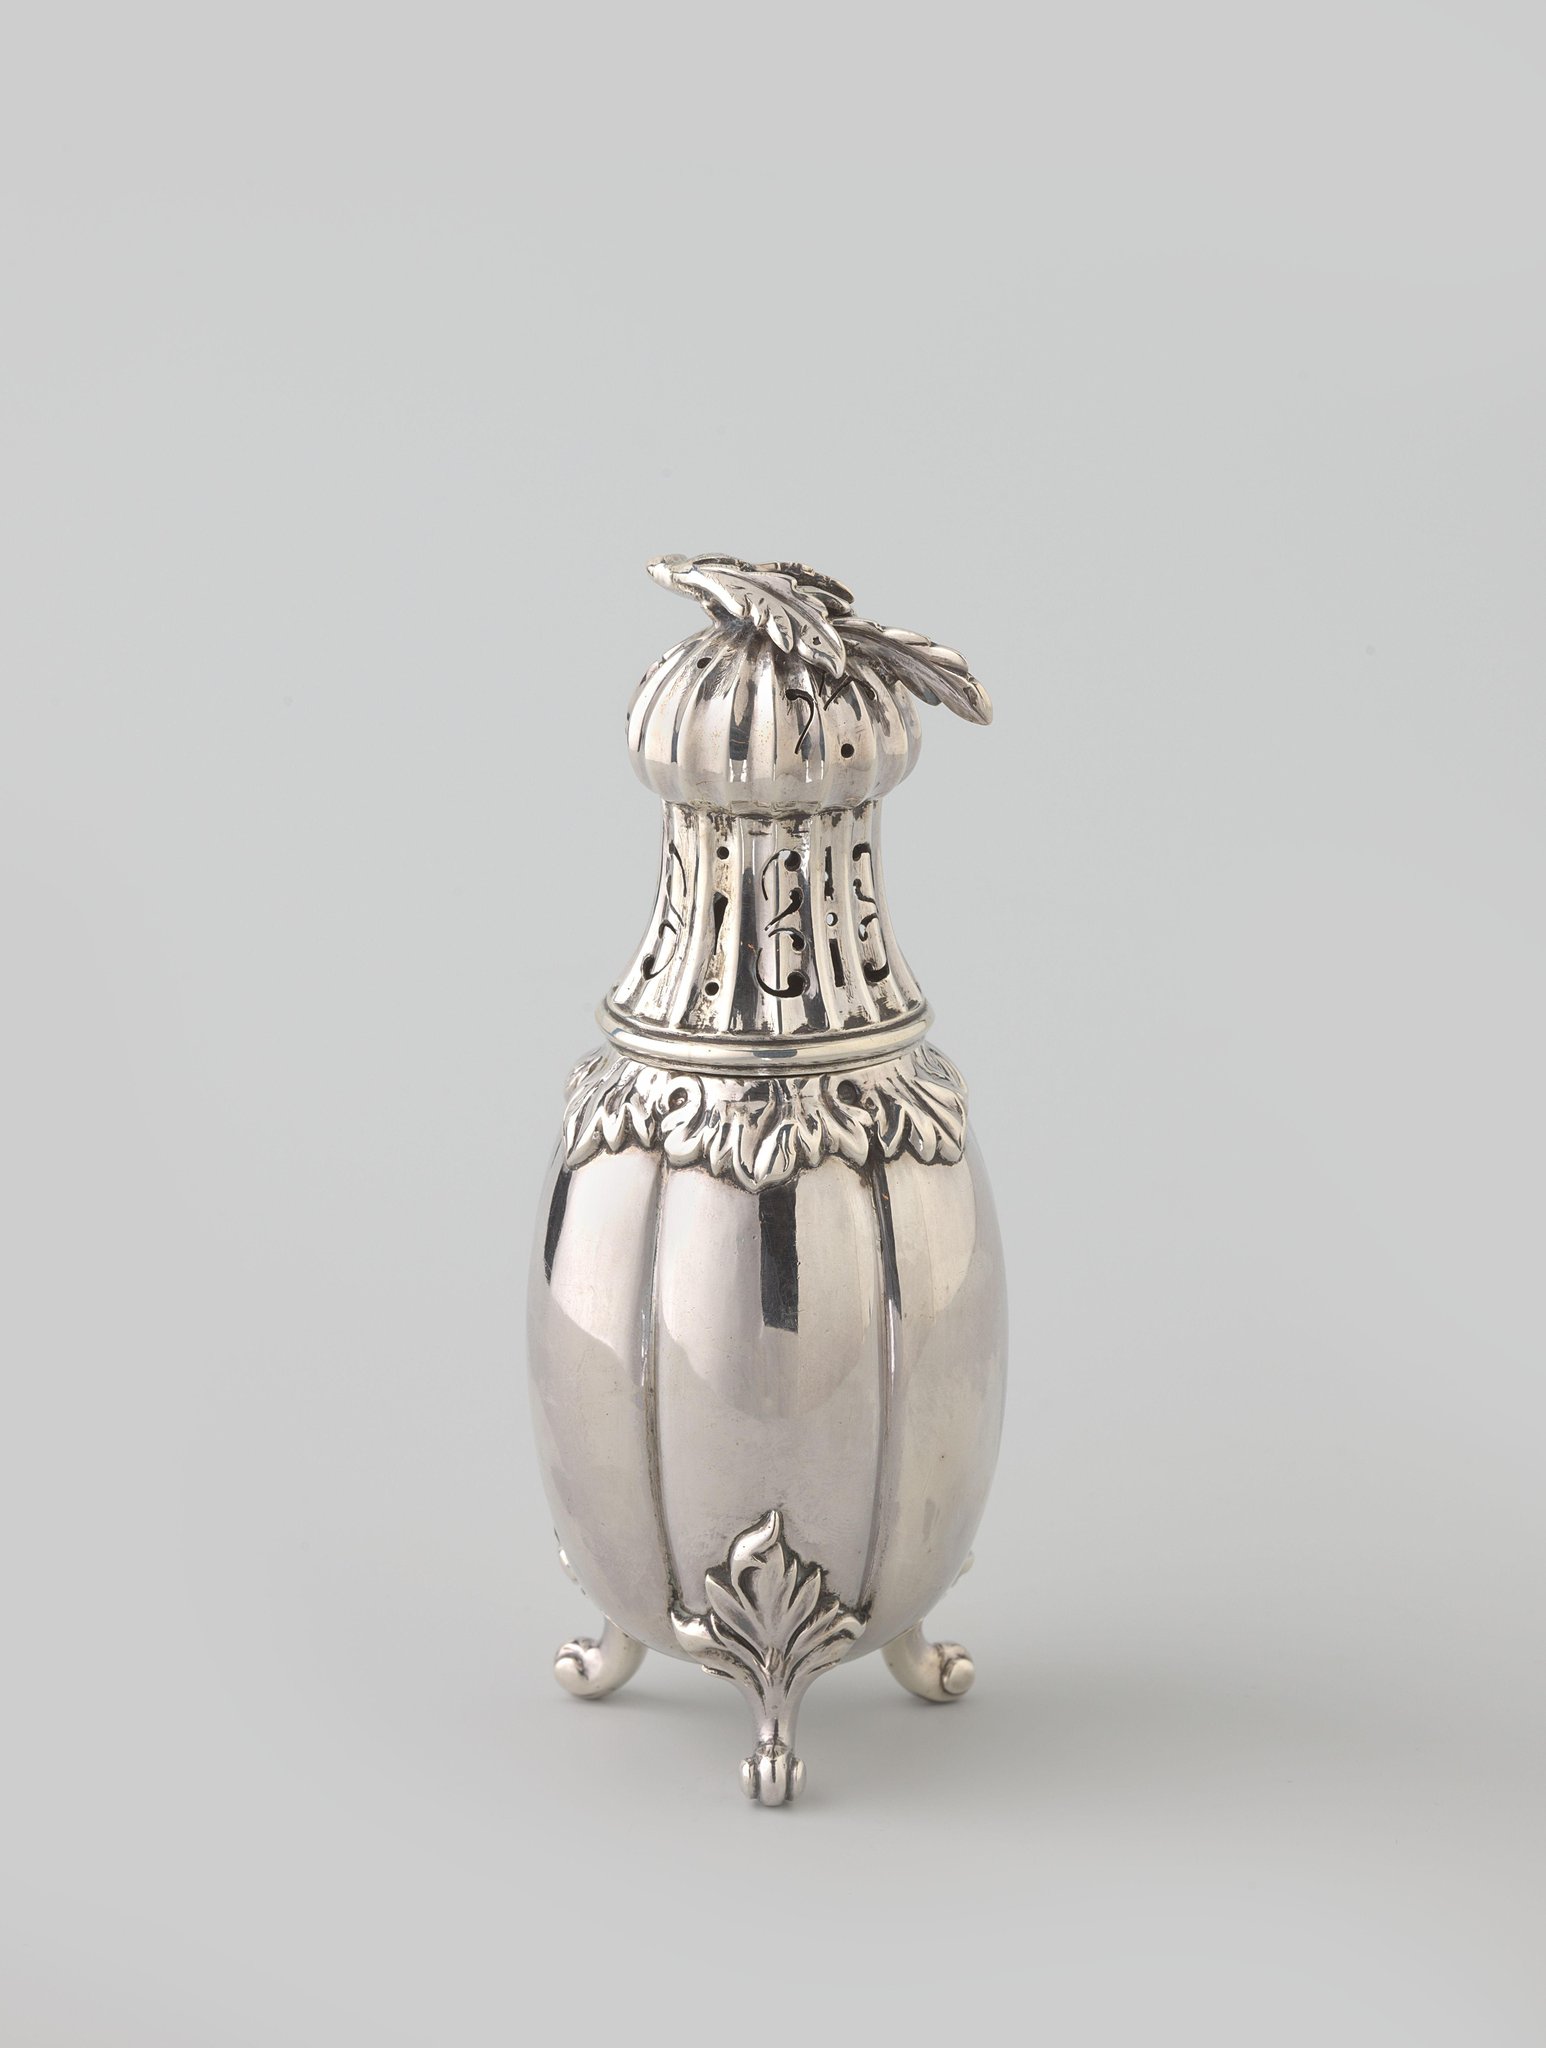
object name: strooibus, strooier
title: Strooibus met meloenvormig lichaam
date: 1944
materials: silver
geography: amsterdam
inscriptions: duty mark (): ‘I’, date letter (false): ‘B’, maker's mark (false), town mark (false), alloy mark (false)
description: De gelijke strooibussen hebben een hoog, meloenvormig, in zes parten ingesnoerd vat, rustend op drie voluutvormige pootjes met een aanzet in de vorm van een blad. Aan de bovenzijde is een rand gemonteerd, opgebouwd uit een repeterend motief van blaadjes. De dop bestaat uit een verjongende hals en een koepelvormige bovenzijde. Hij is geheel geribd en opengewerkt met een patroon van voluten, rondjes, tranen en rechthoekjes, en wordt bekroond door een eikenblaaje. De dop heeft een bajonetsluiting.